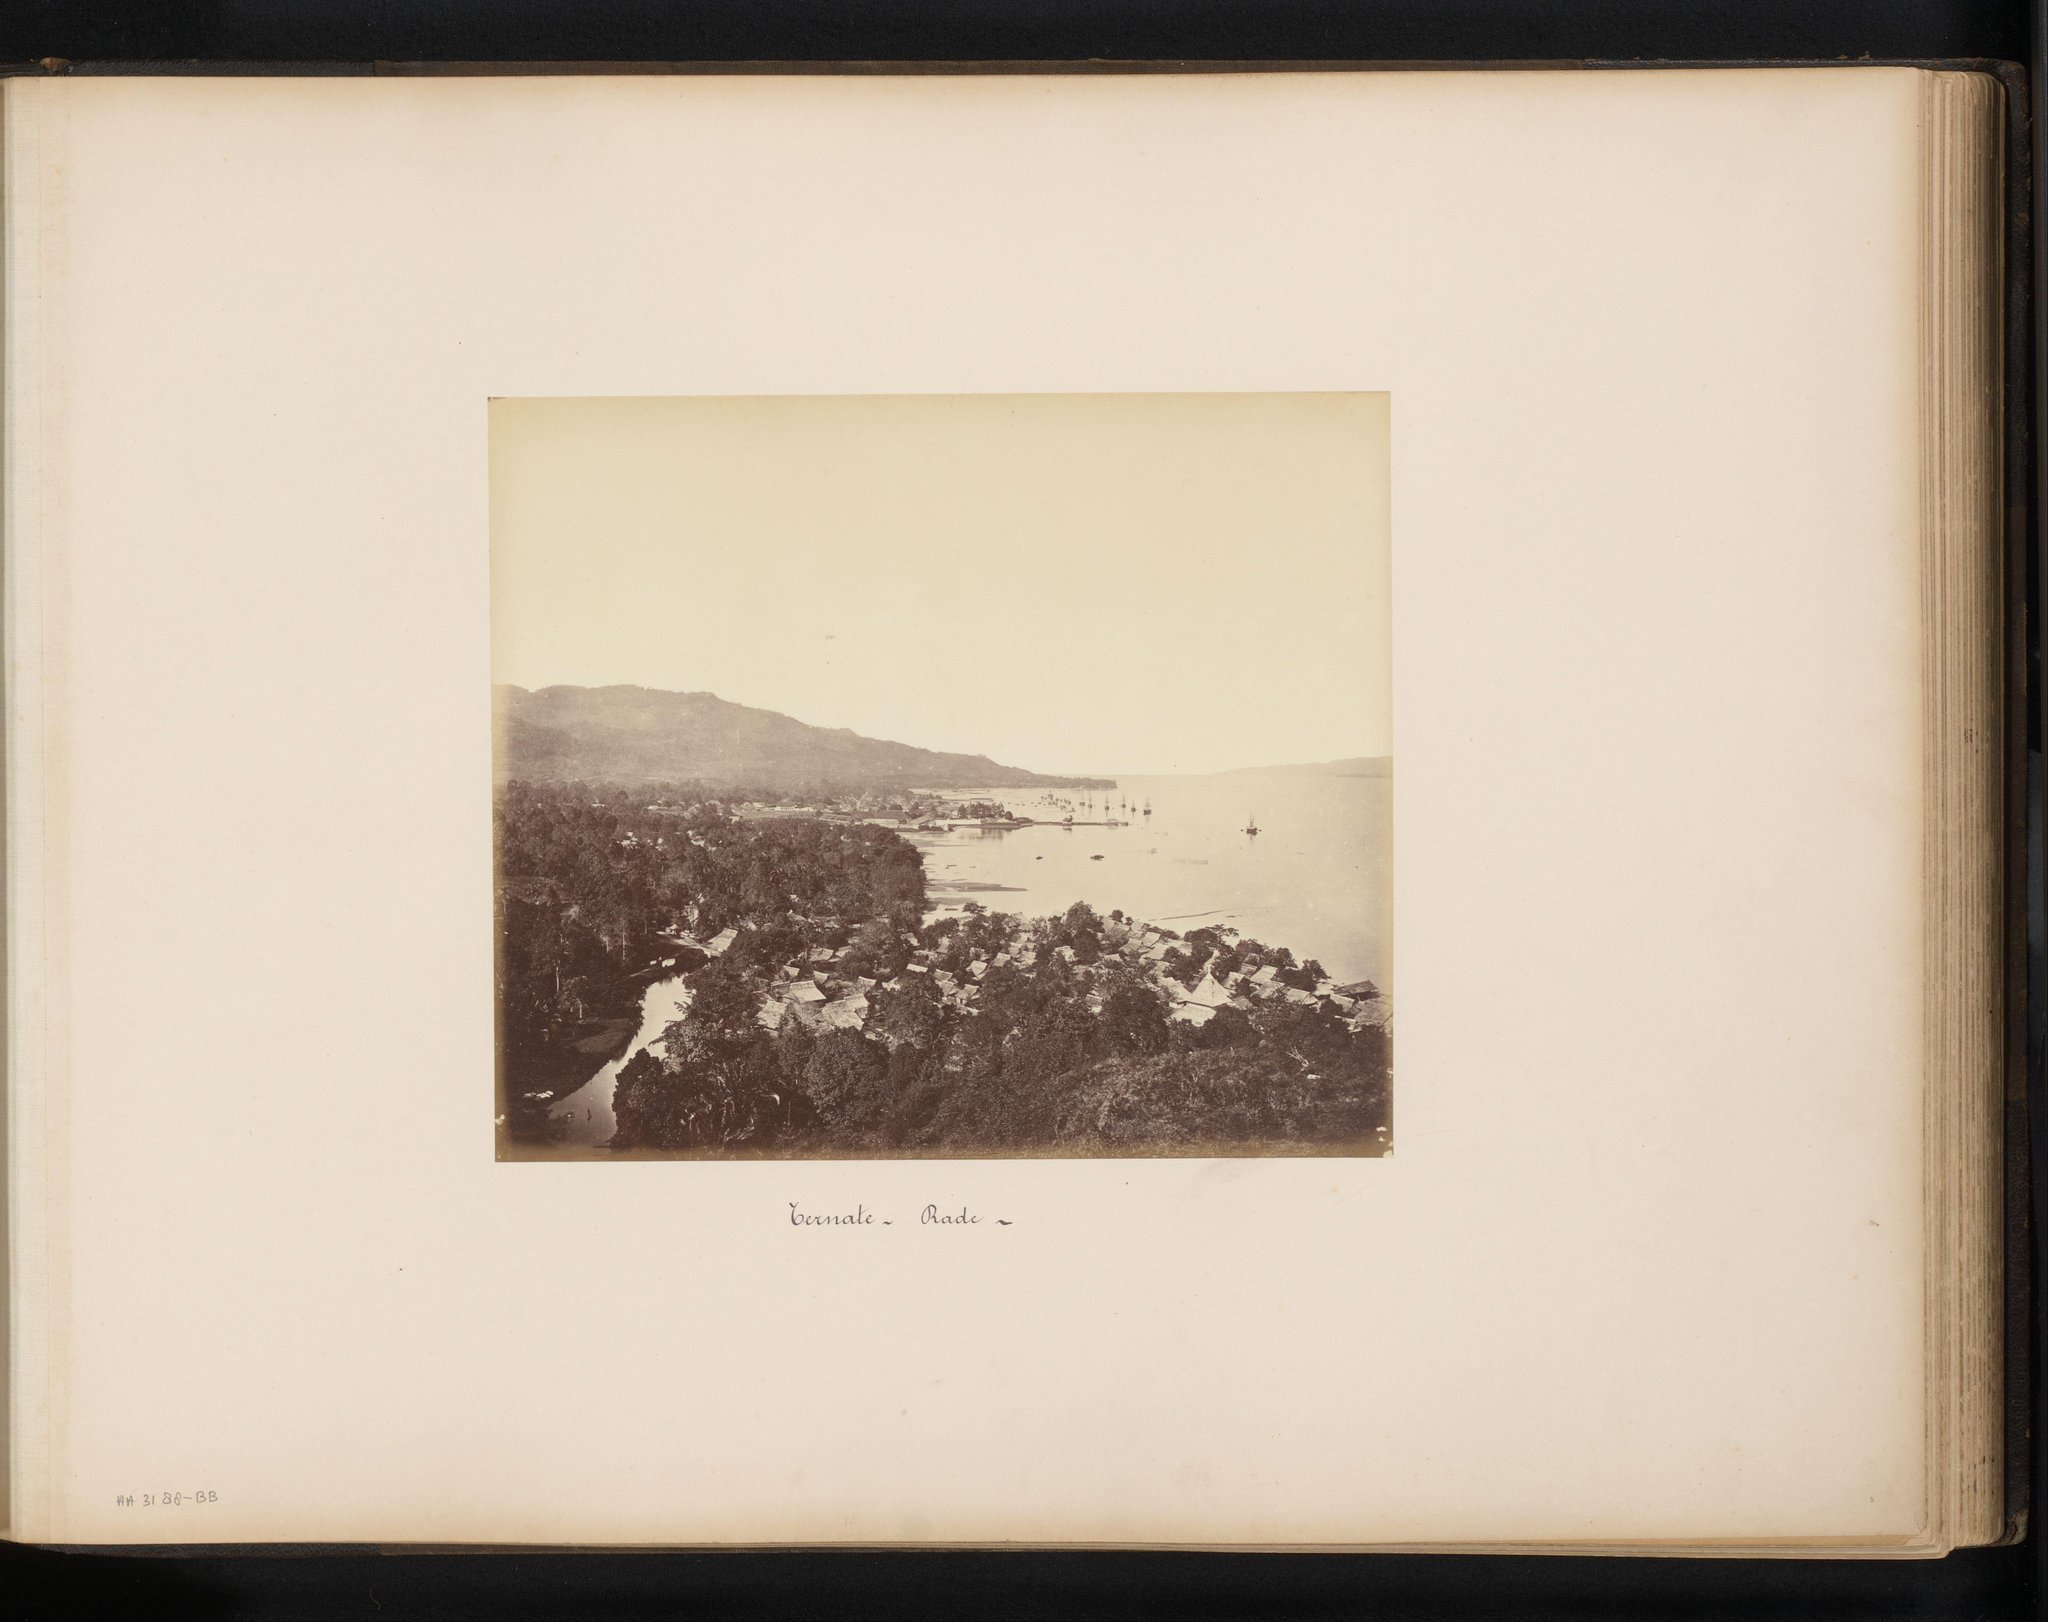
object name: photograph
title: Gezicht op de rede van Ternate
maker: Anonymous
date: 1880-1883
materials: photographic support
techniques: albumen print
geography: ternate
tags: prospect of village, silhouette of village, harbour (+ view ~ vehicle, ship, etc.)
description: Onderdeel van Reisalbum met opnames van bezienswaardigheden in Egypte, Nederlands-Indië, Singapore en Ceylon.